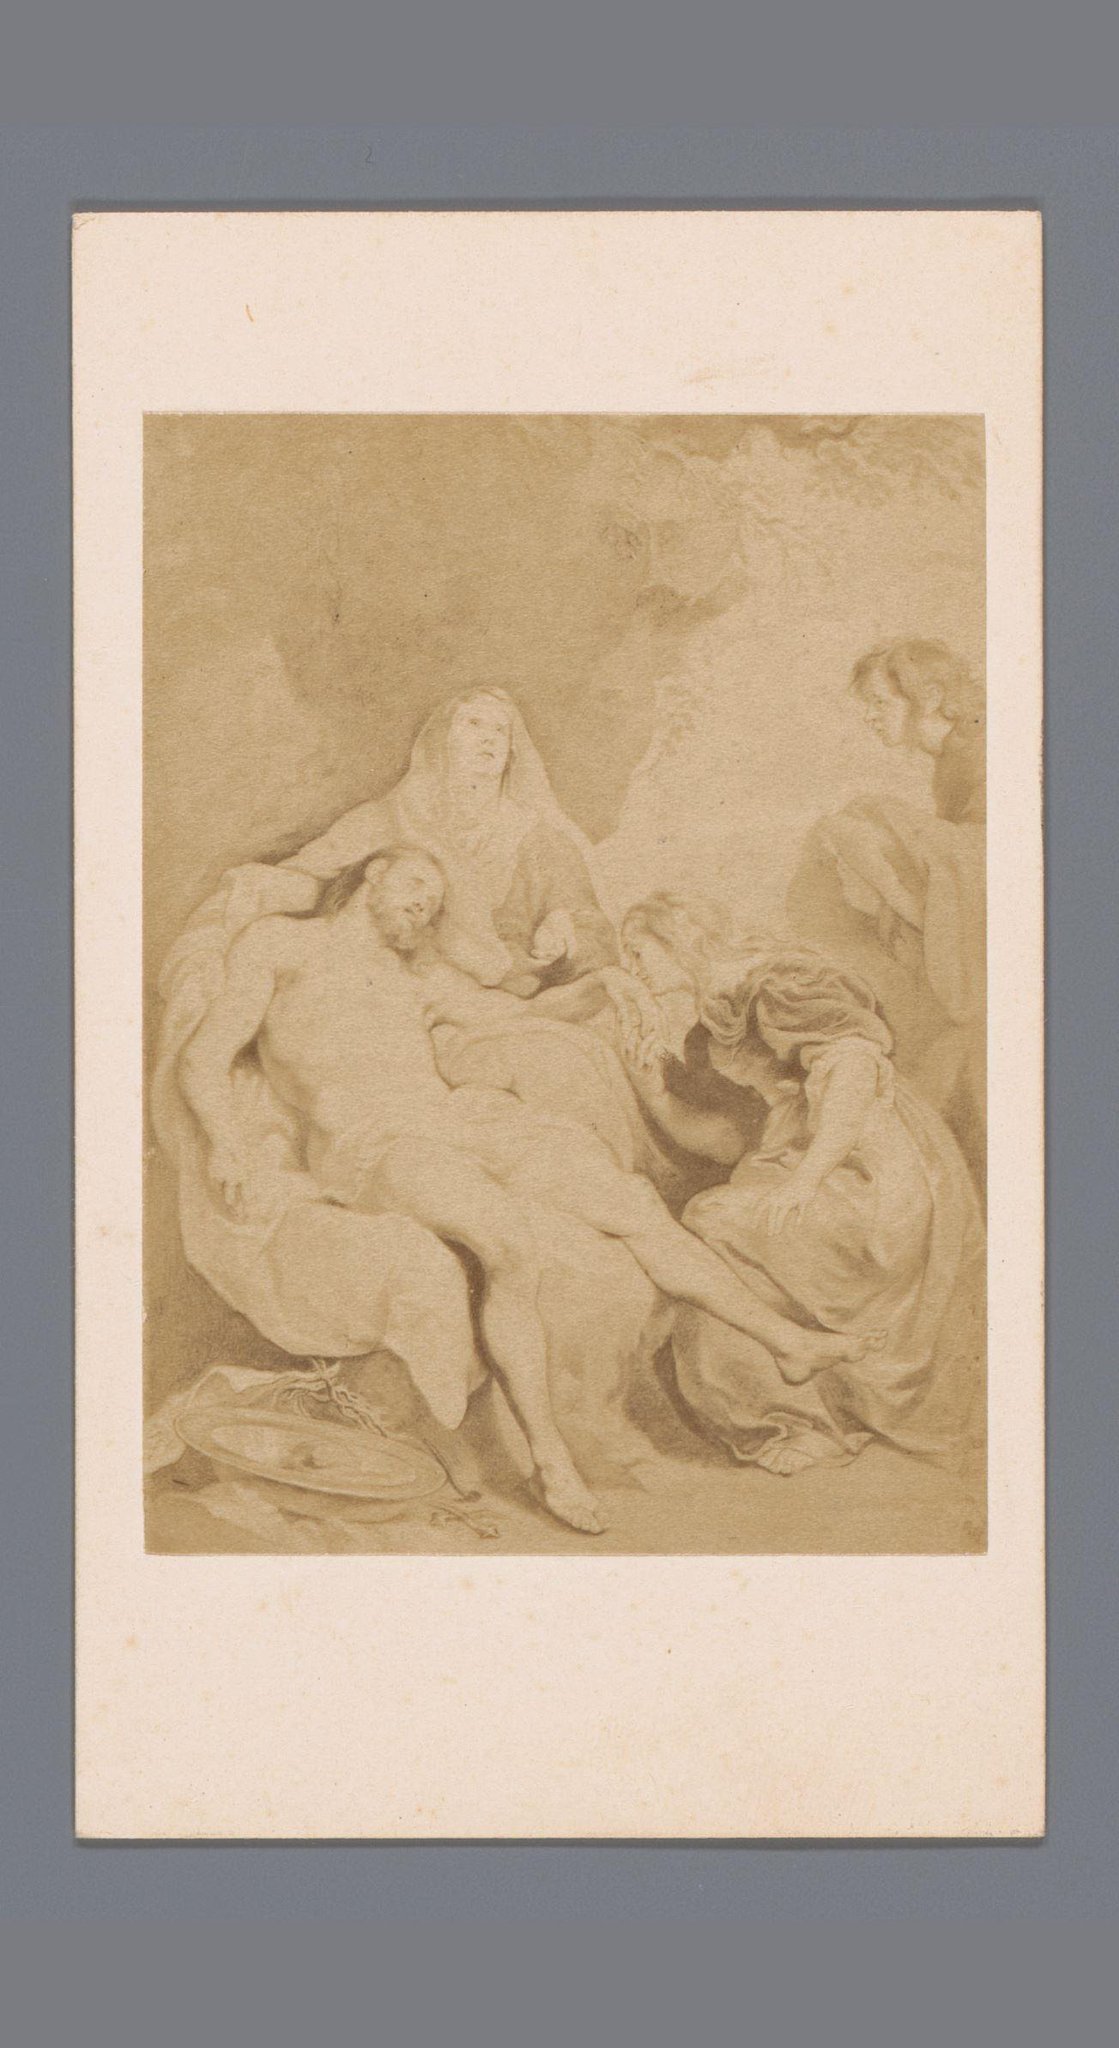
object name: reproduction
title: Fotoreproductie van het schilderij De bewening van Christus, van Anthony van Dyck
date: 1858-1866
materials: cardboard, paper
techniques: albumen print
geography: antwerp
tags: lamentation over the dead christ by his relatives and friends (christ usually without crown of thorns)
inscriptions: inscription: ‘F. Tessaro/ 37, Marché aux Souliers, 37./ Anvers/ Grand Assortiment/ de/ photographies en tous genres’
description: Het schilderij bevindt zich tegenwoordig onder de naam Pietà in de collectie van het Museo del Prado, Madrid.